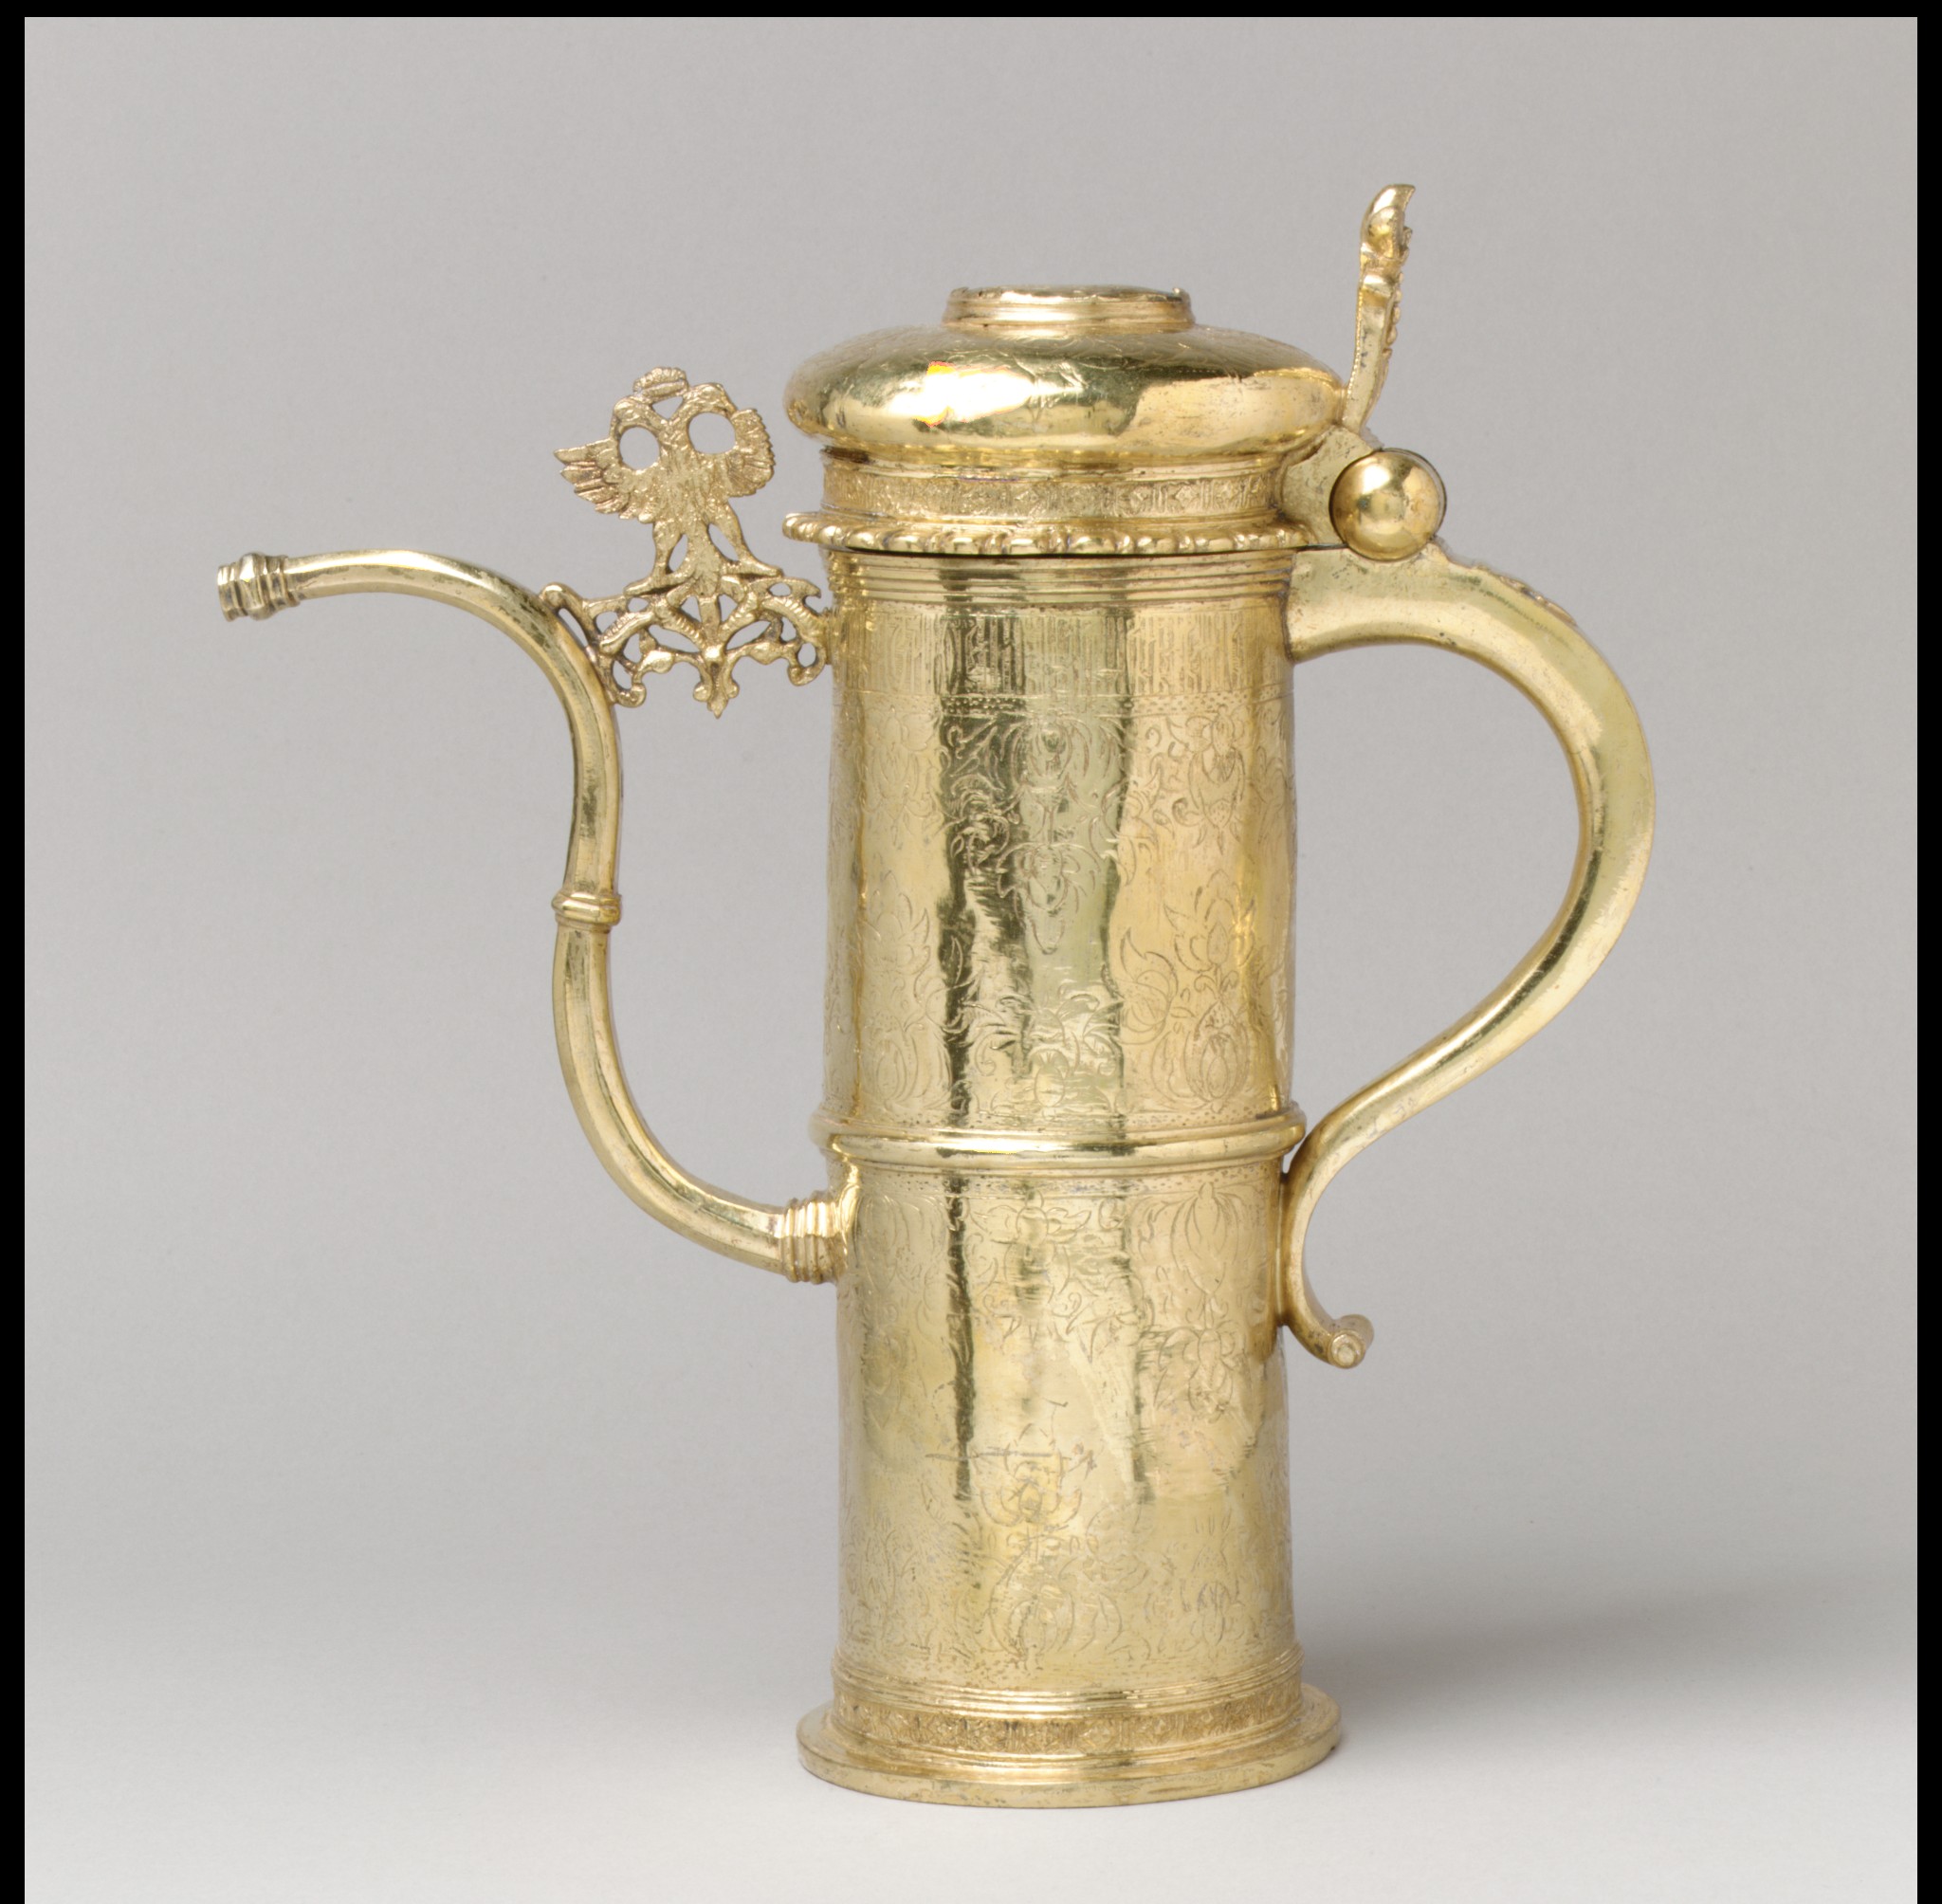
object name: tankard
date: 1801-1900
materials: metal, silver